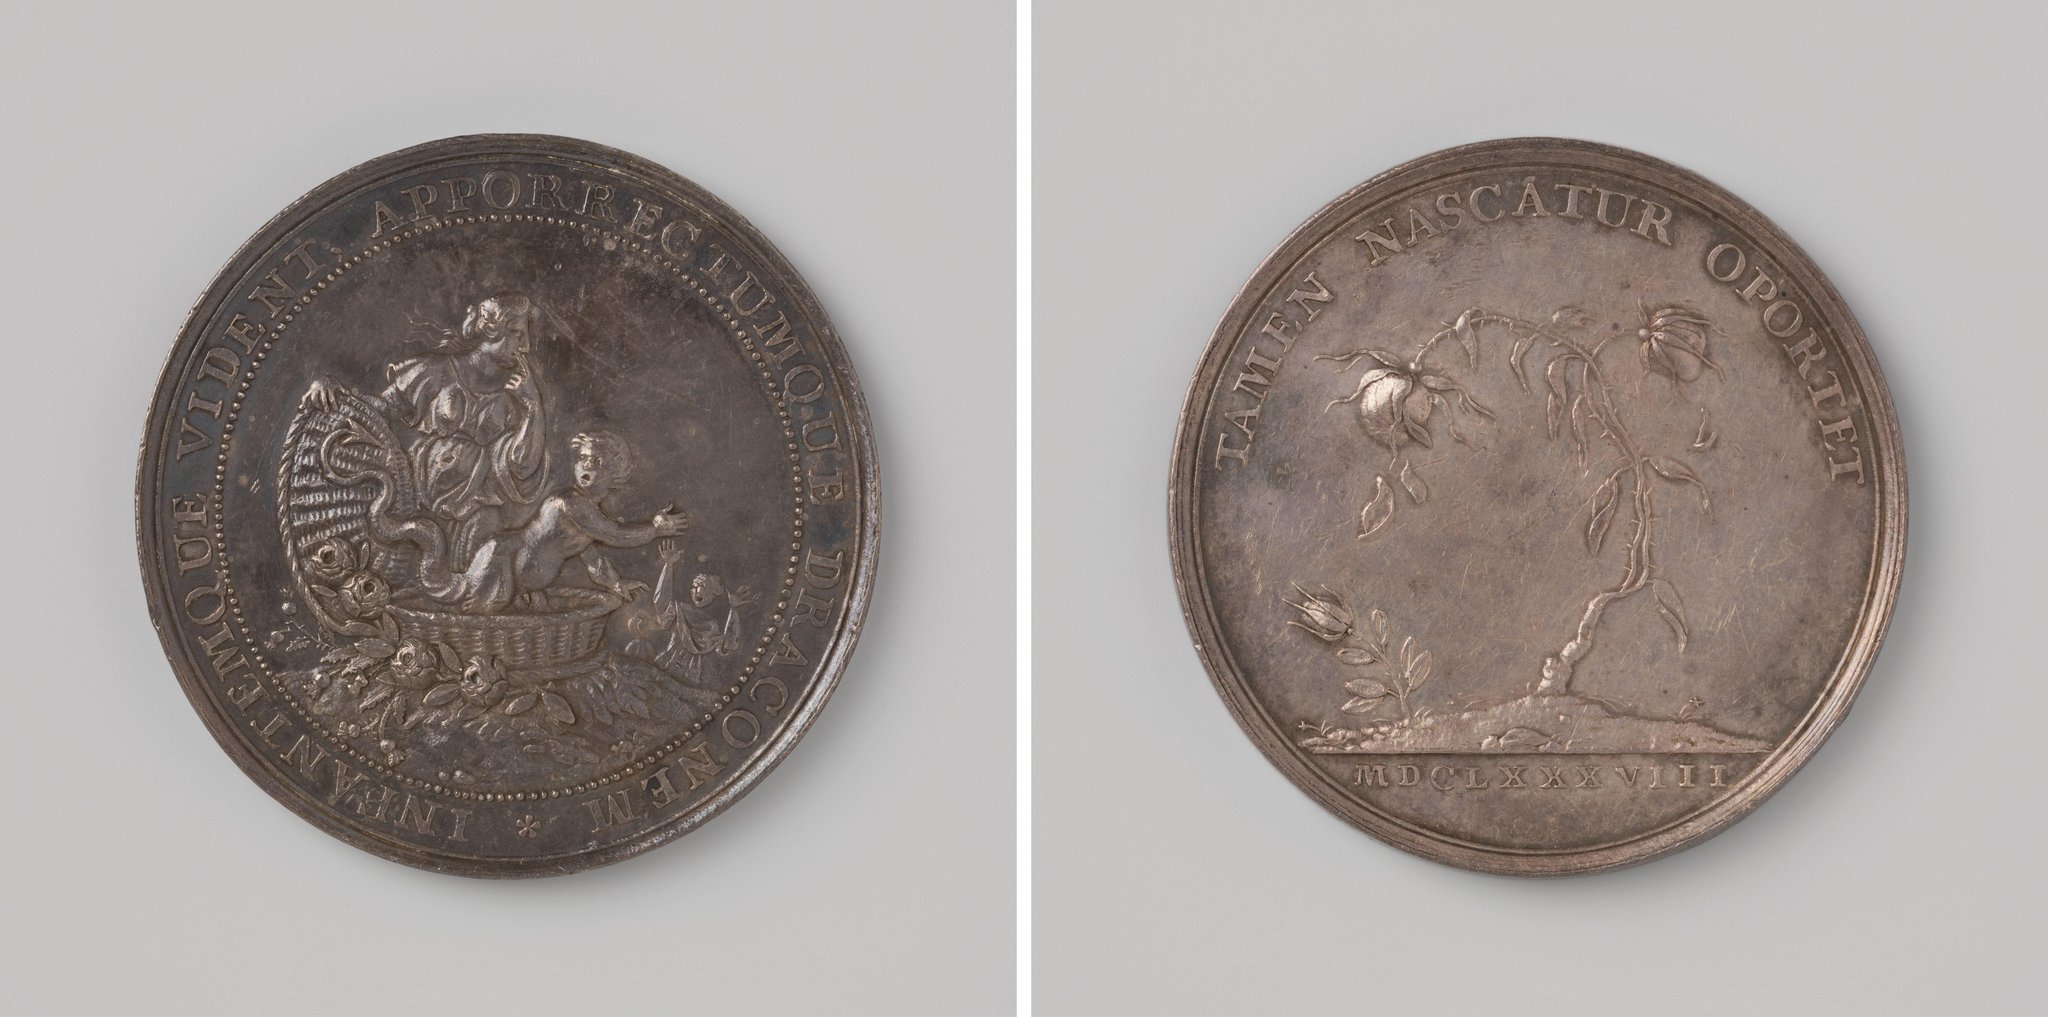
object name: history medal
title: Geboorte van Jacobus Frans Eduard, prins van Wales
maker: jan smeltzing (i)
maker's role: modelleur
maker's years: 1656-1693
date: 1688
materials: silver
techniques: striking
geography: leiden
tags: rome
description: Zilveren penning. Voorzijde: Aglauros opent de mand en vindt daarin Erichthonius met drakenstaart binnen omschrift. Keerzijde: verwelkte rozenstruik met twee bloemen naast jonge loot binnen omschrift; afsnede: jaartal